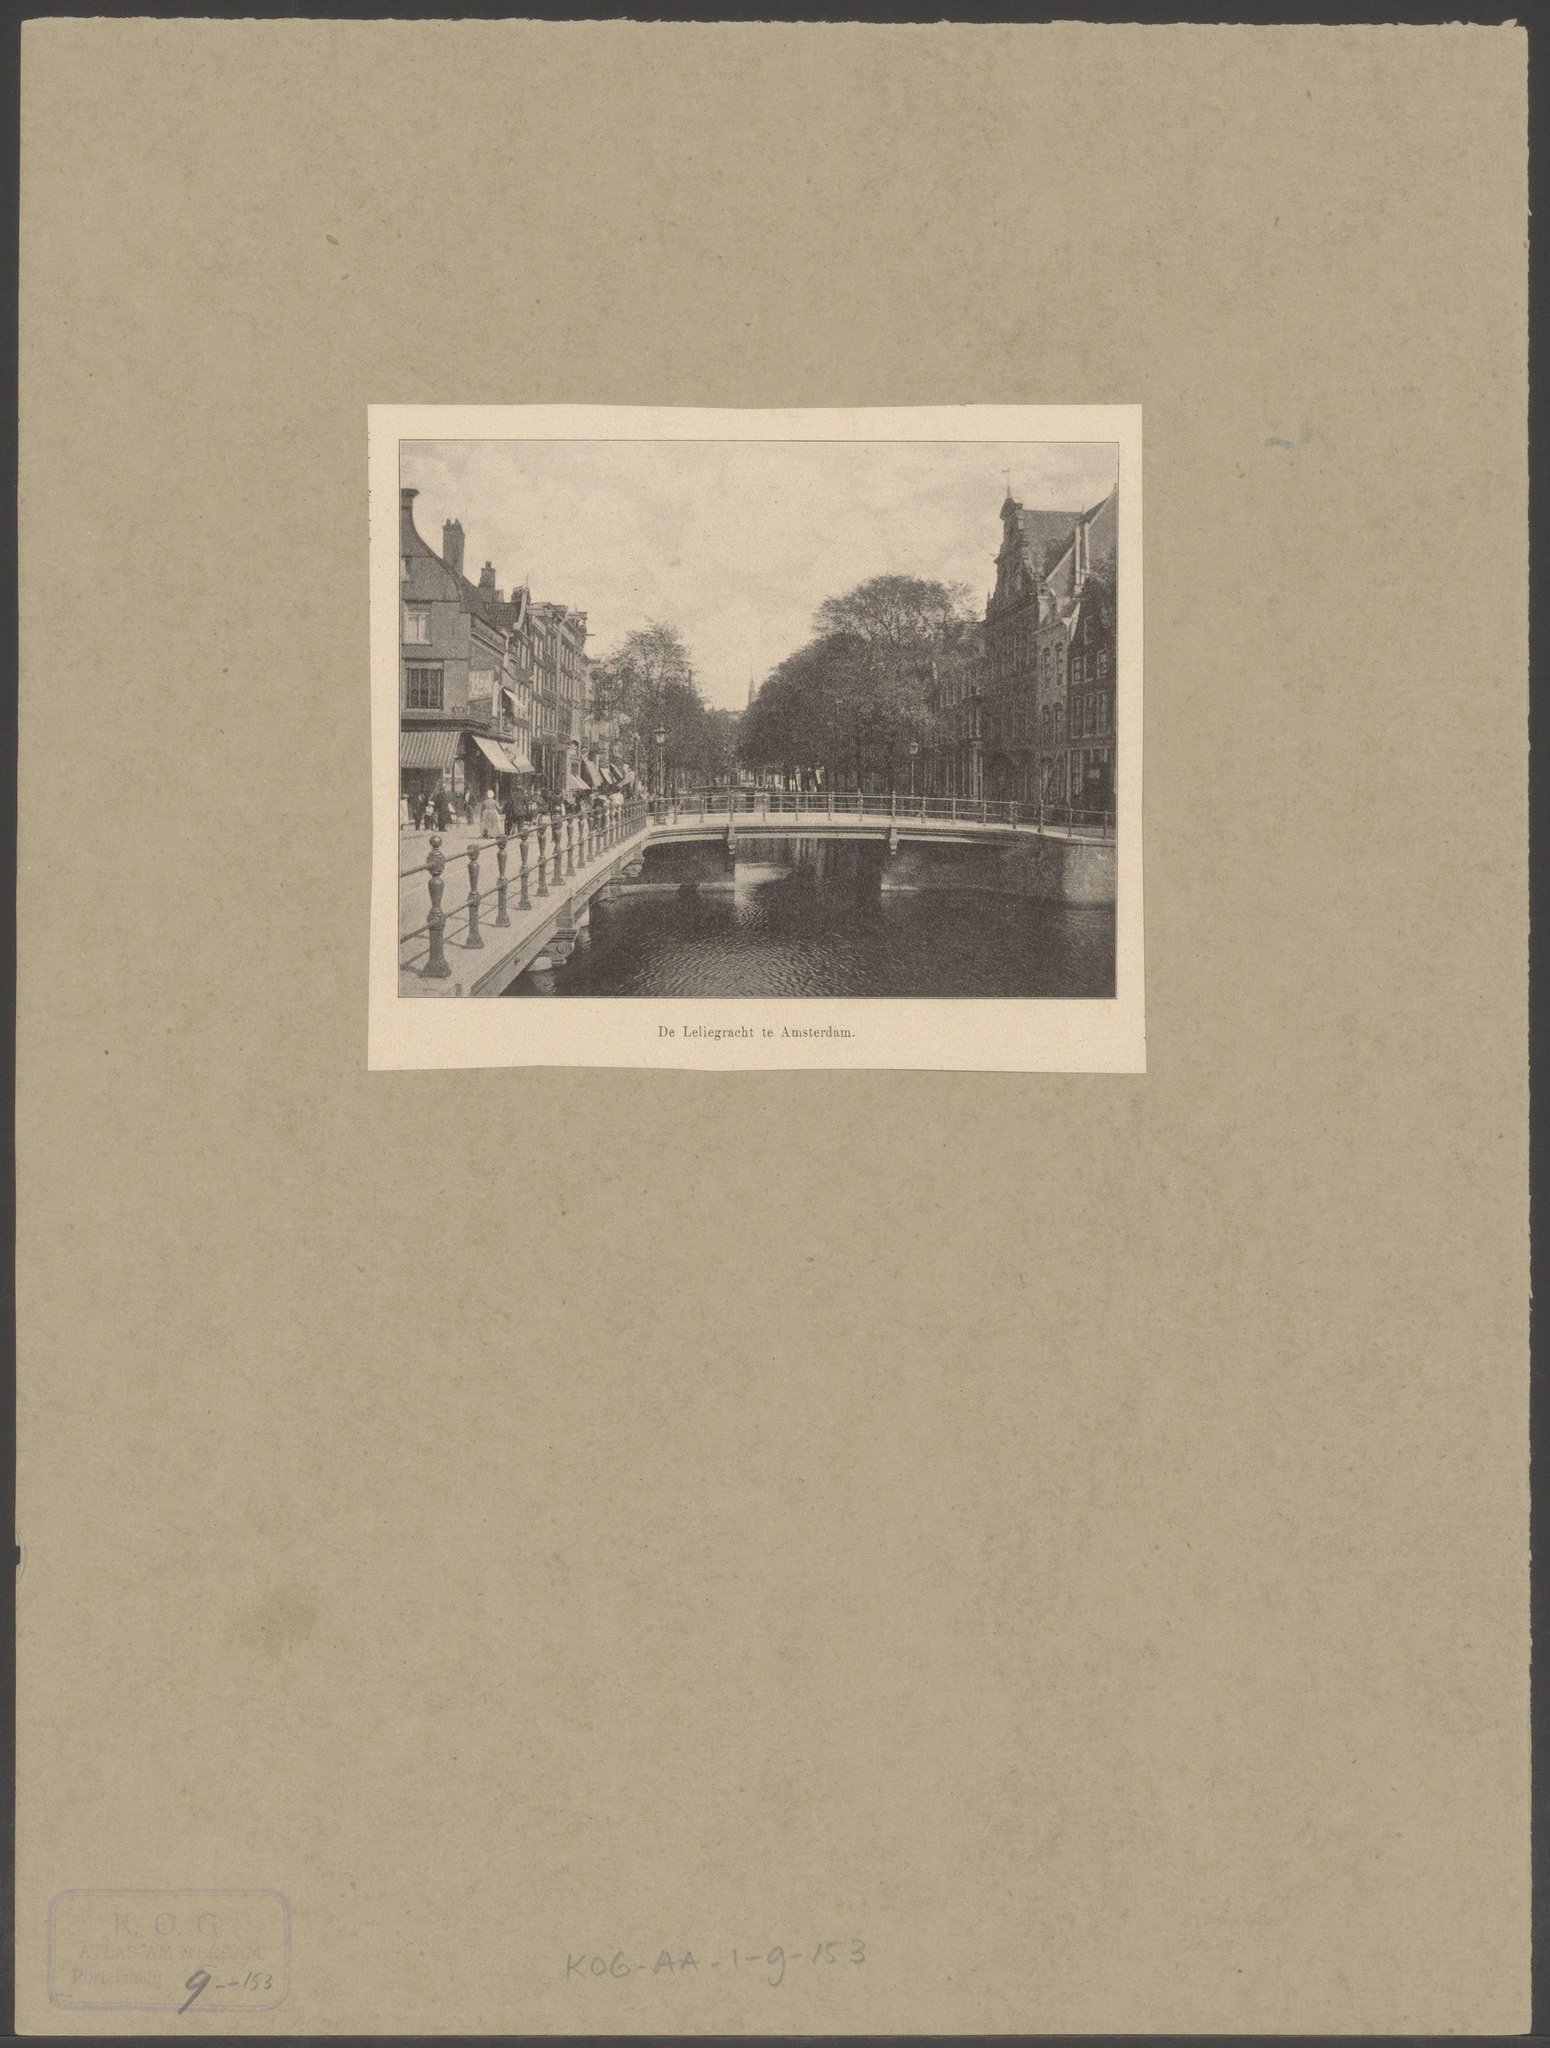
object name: photomechanical print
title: Gezicht op de Leliegracht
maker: Anonymous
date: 1908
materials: paper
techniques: letterpress printing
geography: haarlem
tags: city-view in general; 'veduta', canal, the usual house or row of houses, bridge in city across river, canal, etc.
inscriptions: collector's mark: ‘9.153’ Lugt 1641b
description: Onderwerpsrubriek binnen de Atlas Amsterdam: 2e Laurierdwarsstraat (Vuile Weespad), Leidschegracht, Leidschekade, Leidscheplein, Leidschestraat, v. Lennepkade, Lijnbaansgracht, Lauriergracht, Leliedwarsstraat, Leliegracht, Lindengracht, Lombardsteeg, Looiersgracht, Looiersstraat (Nieuwe), Leidekkerssteeg.